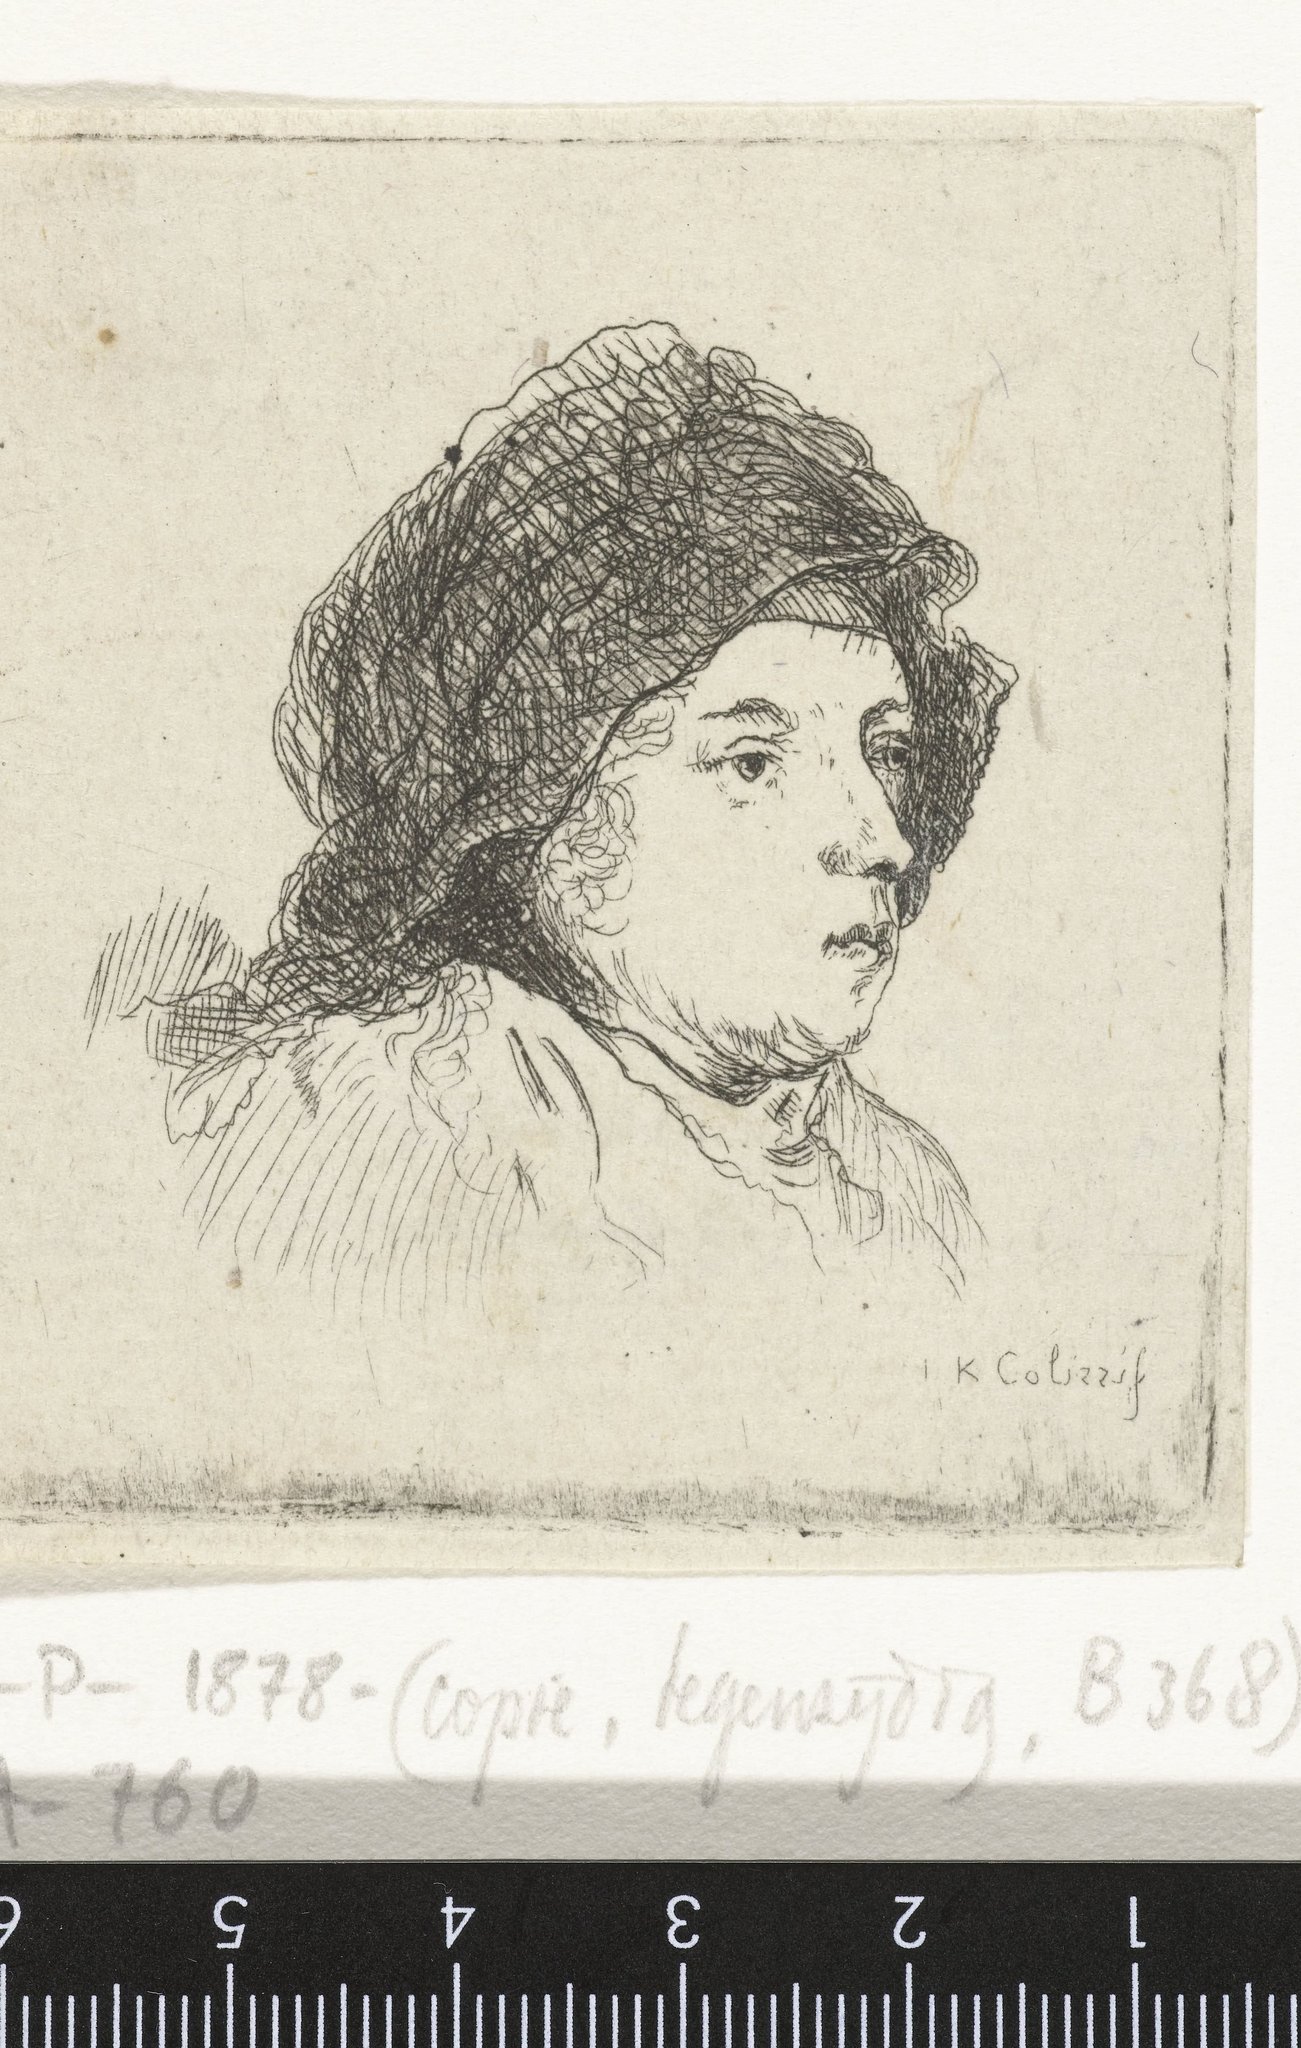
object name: print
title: Portret van een jonge vrouw met hoofddoek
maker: johan antoni kauclitz colizzi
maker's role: print maker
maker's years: 1742-1808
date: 1774-1808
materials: paper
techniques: etching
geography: netherlands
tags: anonymous historical person portrayed alone - bb - woman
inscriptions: collector's mark: Lugt 2227